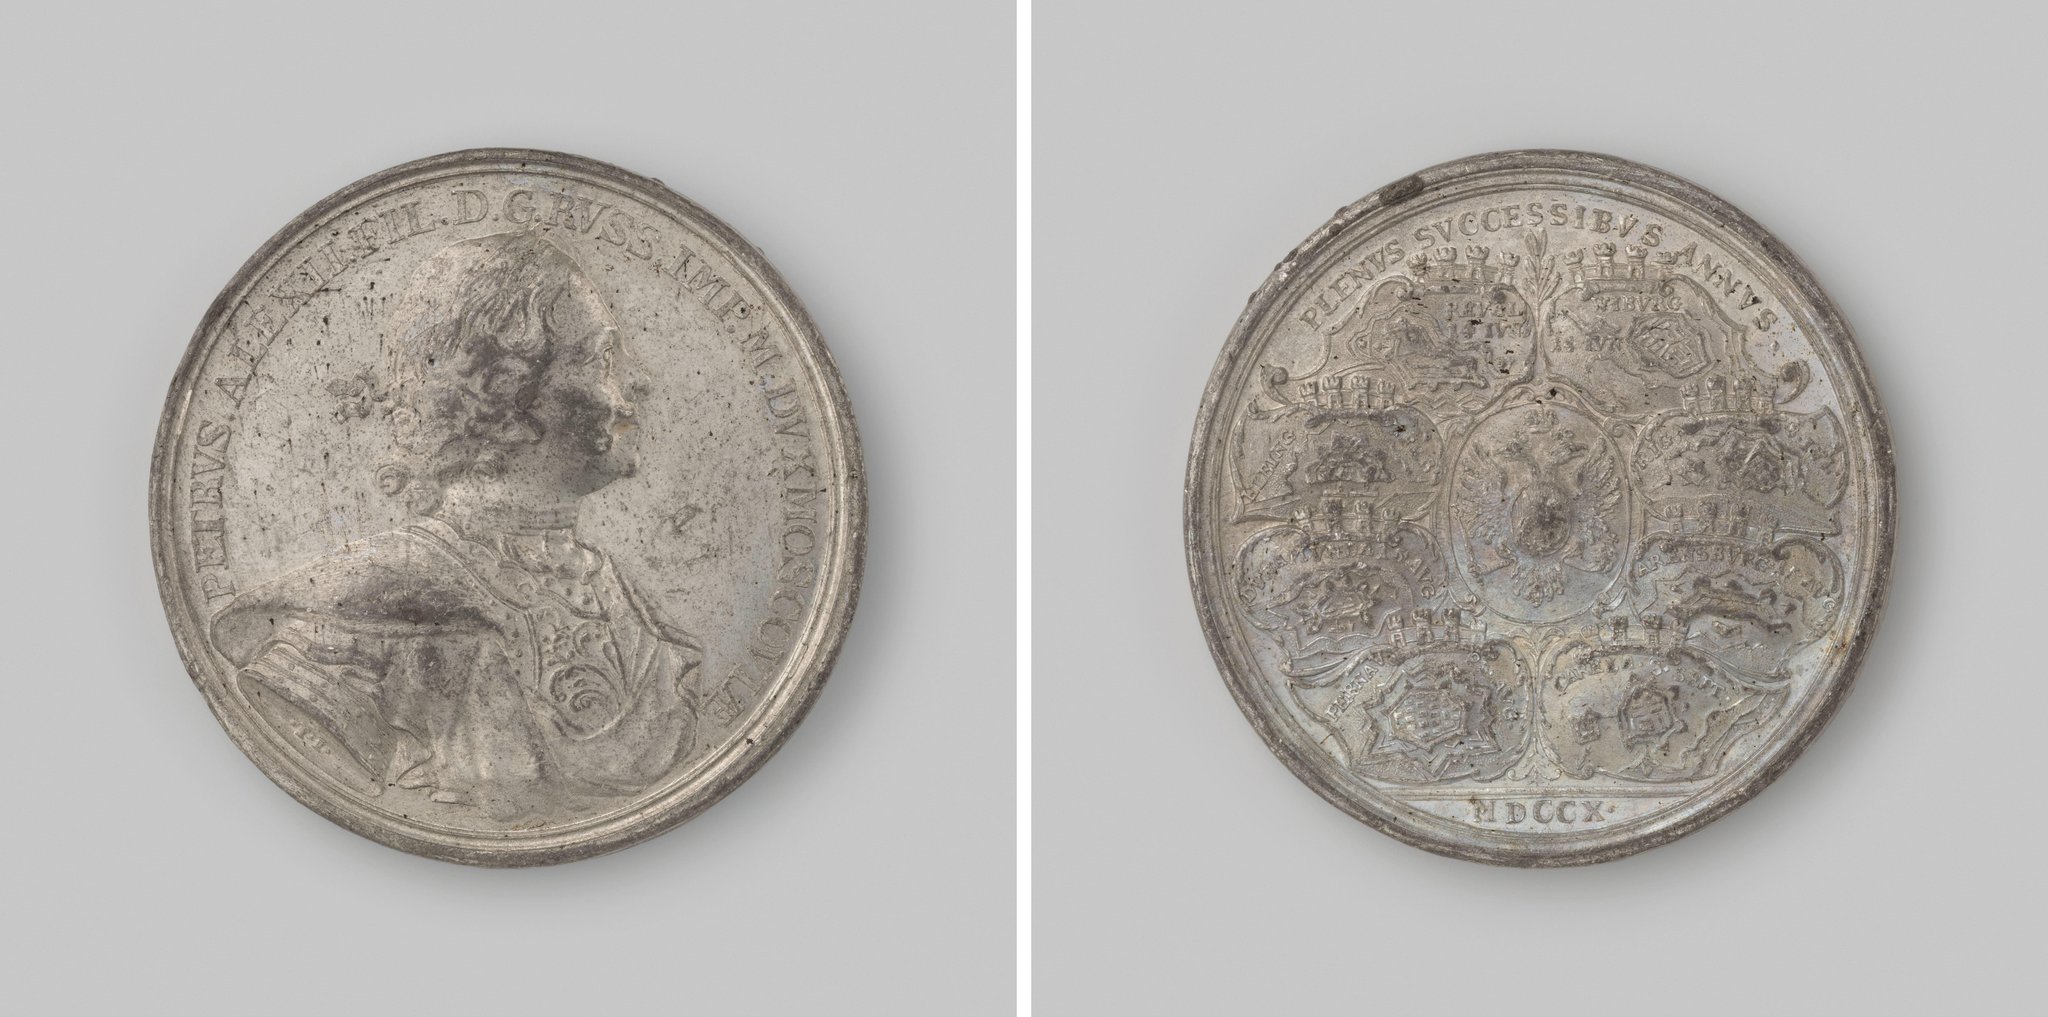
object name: history medal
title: De militaire successen van Rusland in 1710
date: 1710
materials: tin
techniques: striking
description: Tinnen penning, op de voorzijde het borstbeeld van Tsaar Peter de Grote naar rechts met omschrift, op de keerzijde een ovaal schild met de Russische adelaar waaromheen acht gekroonde cartouches met de plattegronden van veroverde steden, met omschrift en afsnedetekst.